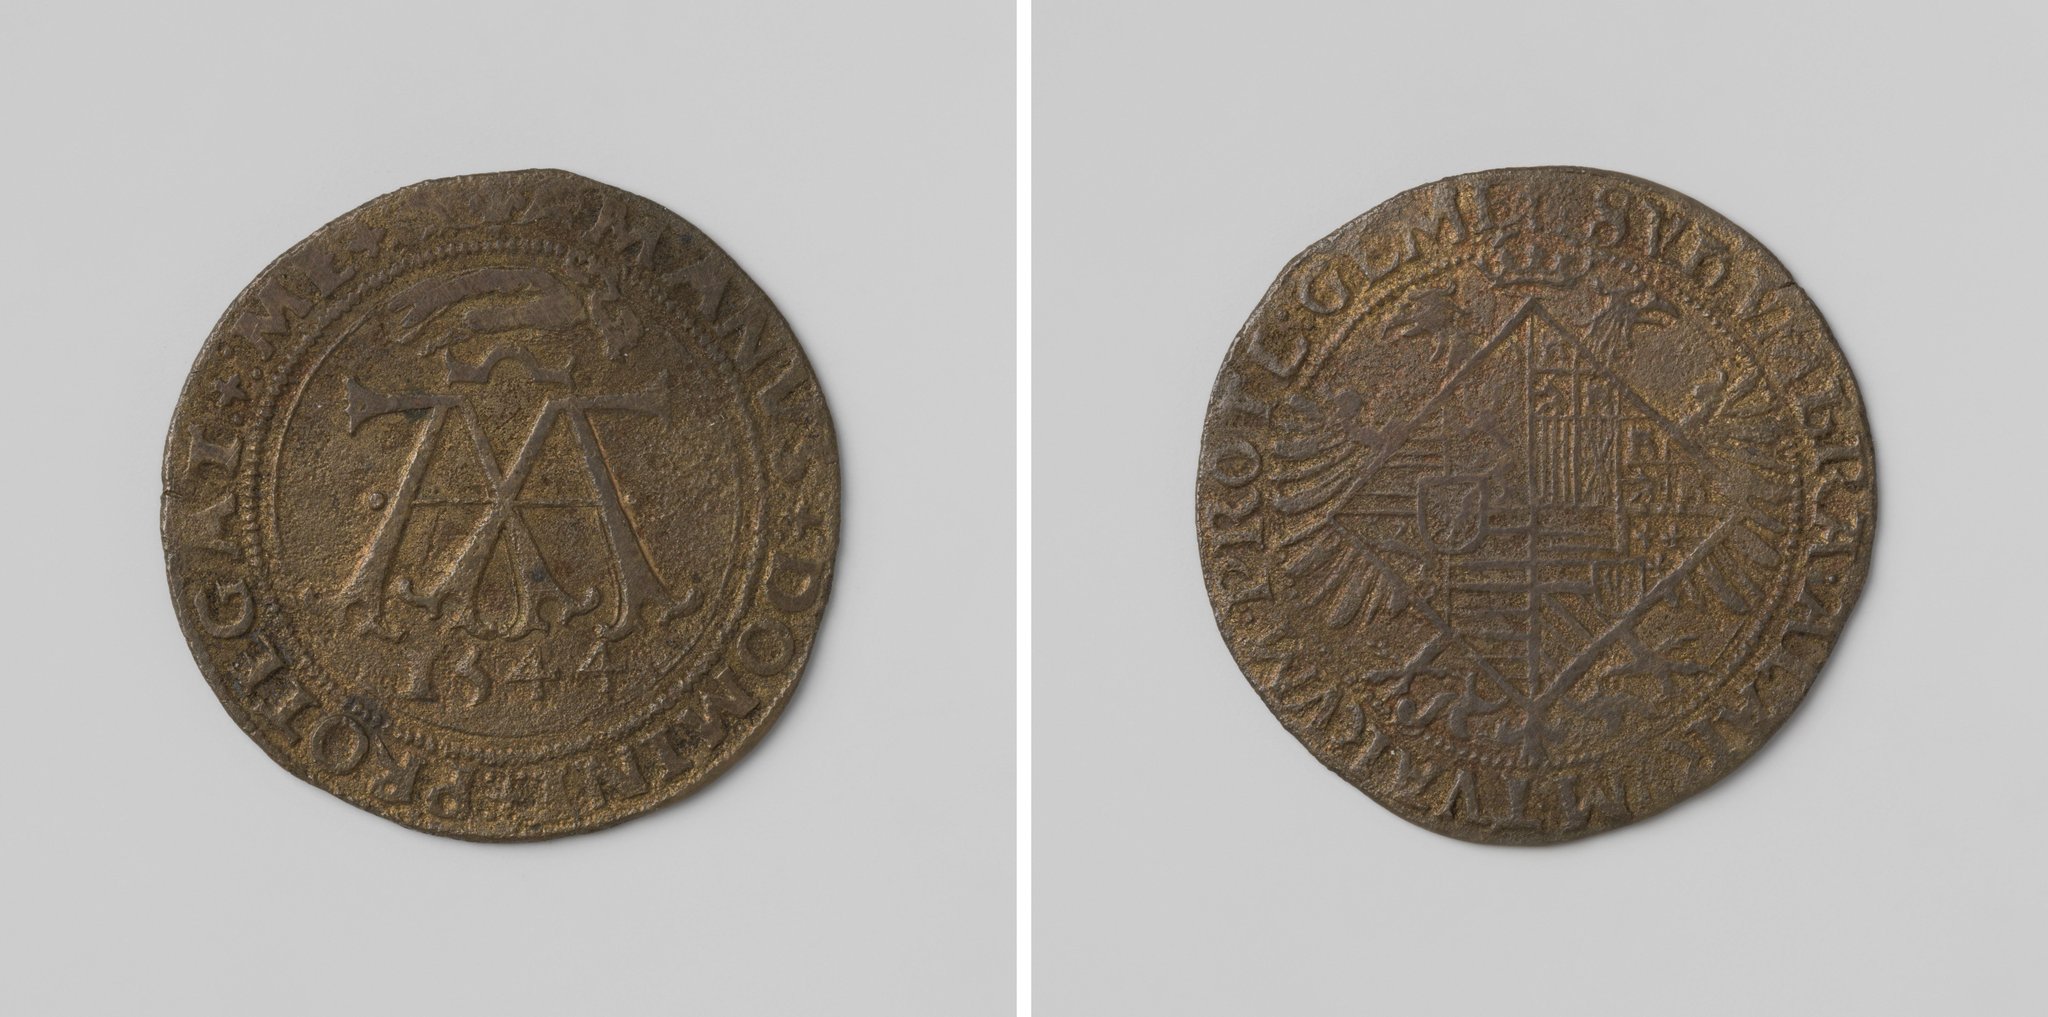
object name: jeton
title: Maria van Hongarije, landvoogdes der Nederlanden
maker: Anonymous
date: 1544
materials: copper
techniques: striking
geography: netherlands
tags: brussels, maria van hongarije (landvoogdes der nederlanden)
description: Koperen penning. Voorzijde: letter M onder hand en accolade, boven jaartal binnen omschrift. Keerzijde: tweekoppige adelaar onder kroon houdt ruitvormig wapenschild voor zich binnen omschrift